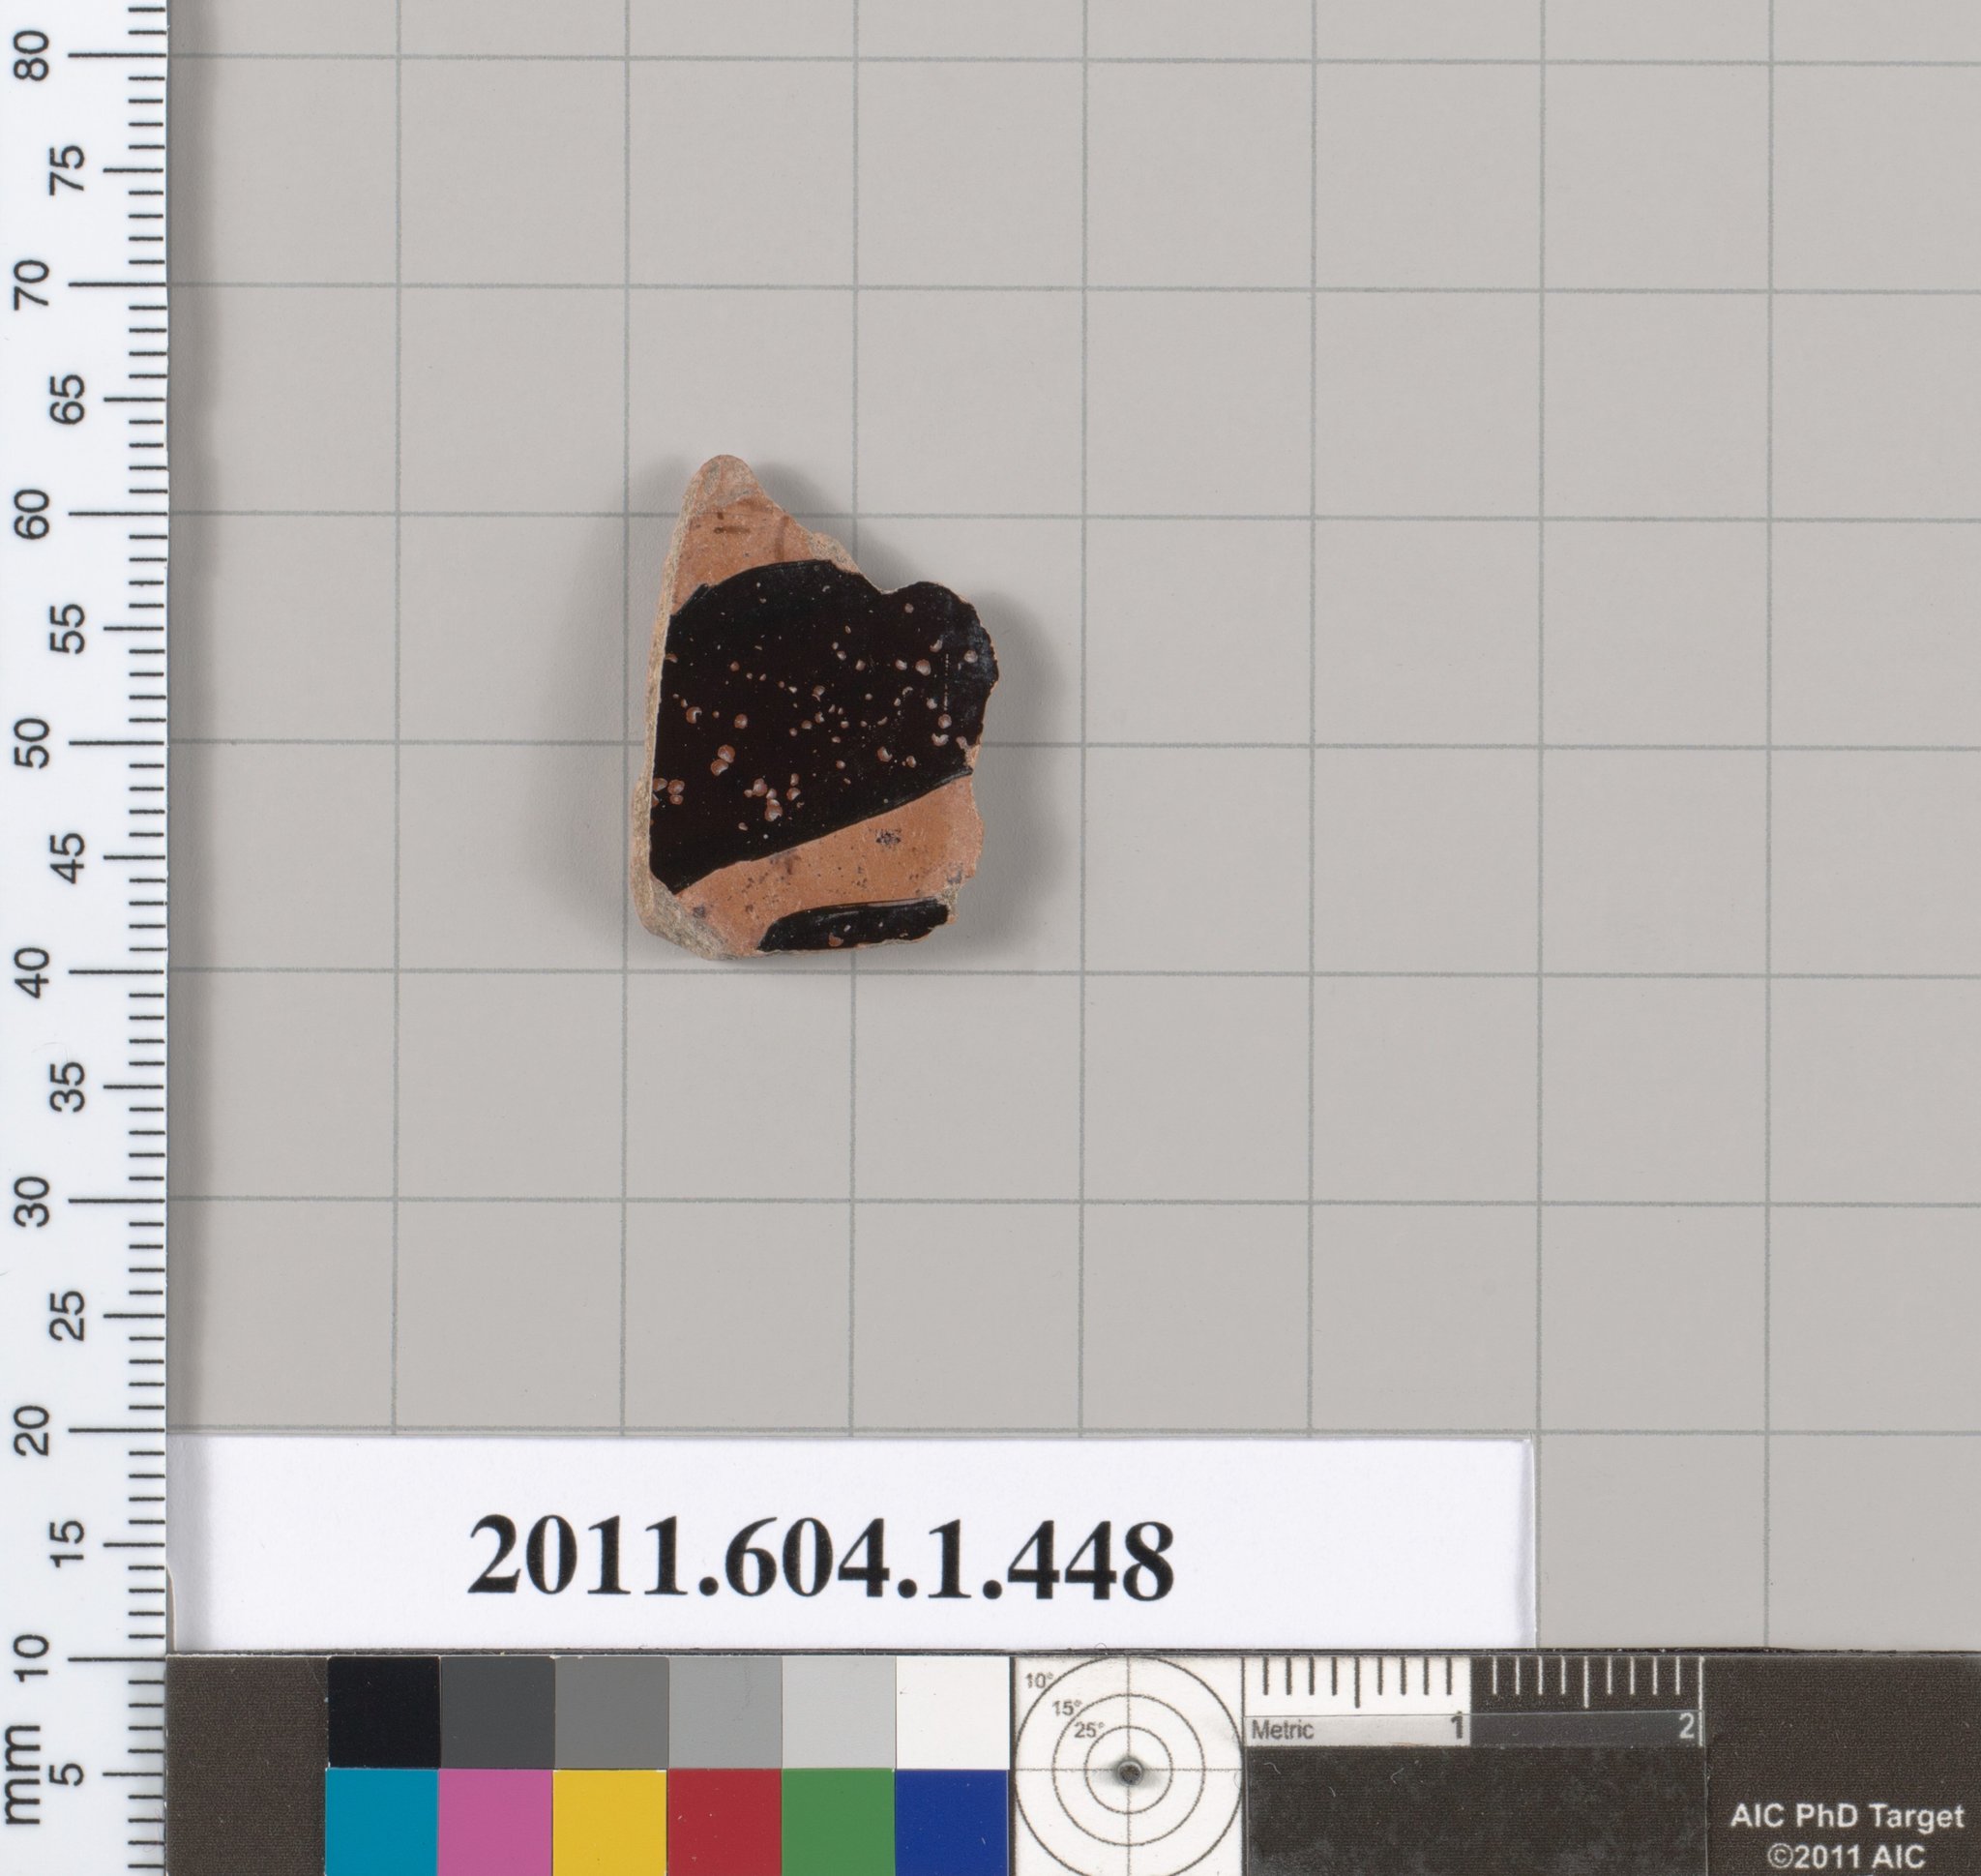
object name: kylix fragment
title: Terracotta fragment of a kylix (drinking cup)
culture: greek, attic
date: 475-451 BCE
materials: terracotta